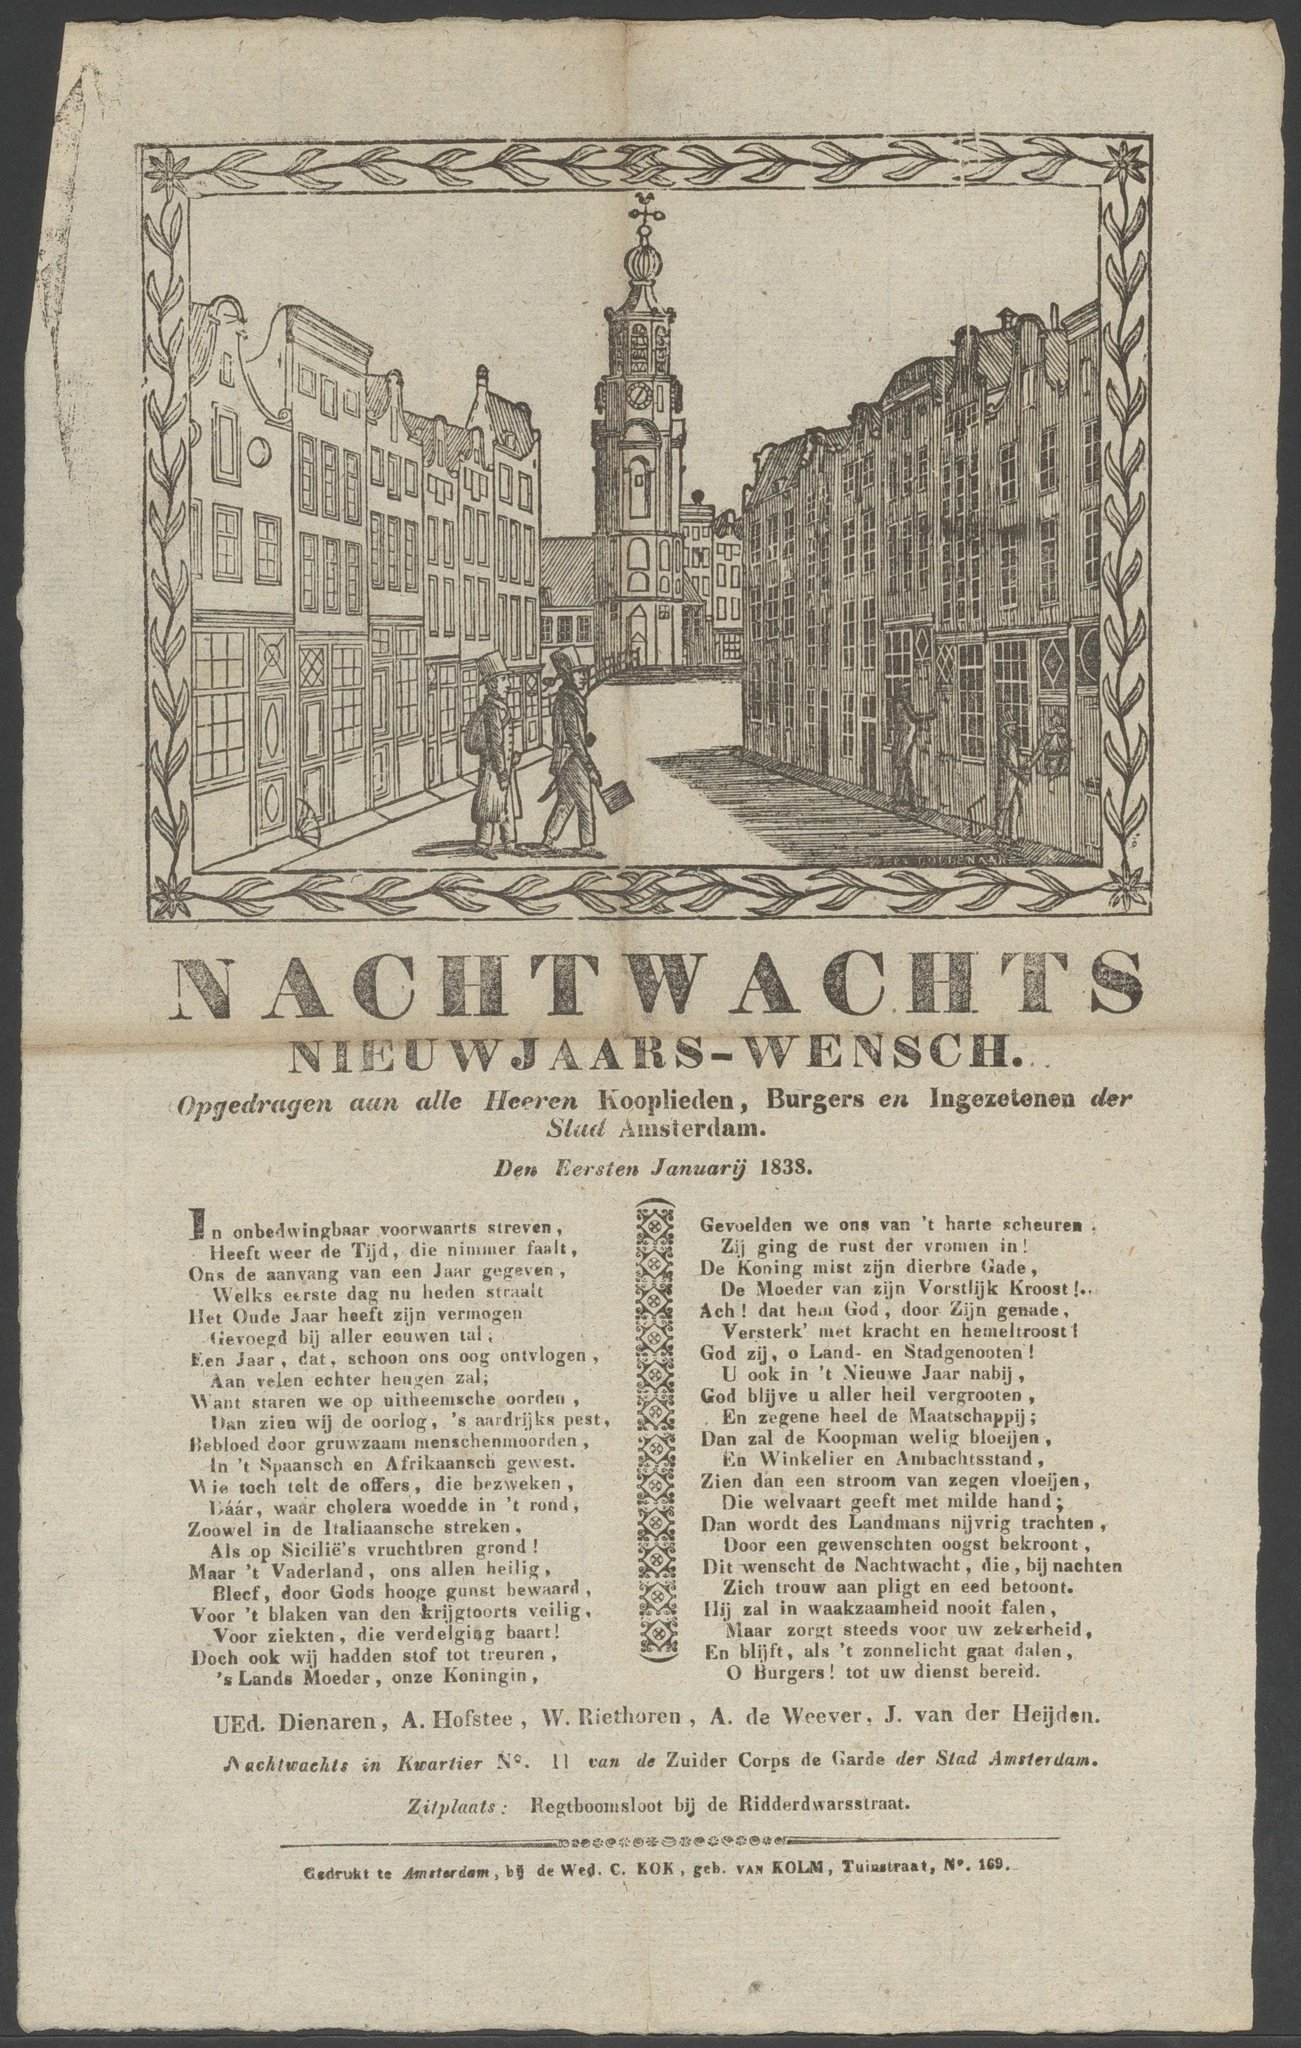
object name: new year card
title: Nieuwjaarswens van de Amsterdamse nachtwacht voor het jaar 1838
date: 1837-1838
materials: paper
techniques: letterpress printing, engraving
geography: amsterdam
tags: night patrol, canals, waters (in city), amsterdam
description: Nieuwjaarswens van de Amsterdamse nachtwacht (ratelwacht) voor het jaar 1838. Twee leden van de nachtwacht lopend met een ratel door een straat (Reguliersbreestraat?) bij de Munt in Amsterdam. Met een vers in twee kolommen. Namens de nachtwacht in kwartier No. 11 van de Zuider Corps de Garde der stad Amsterdam: A. Hofstee, W. Riethoren, A. de Weever en J. van der Heijden. Onderwerpsrubrieken binnen de Atlas Zeden en Gewoonten: Zeden en gewoonten in engeren zin, Volksleven, Volksbladen, Nieuwjaars- en Kerstwenschen, Amsterdam.